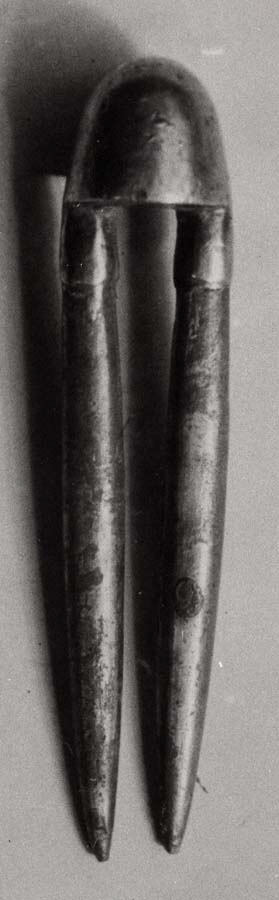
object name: hair pin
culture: korean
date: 901-1400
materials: gold, silver